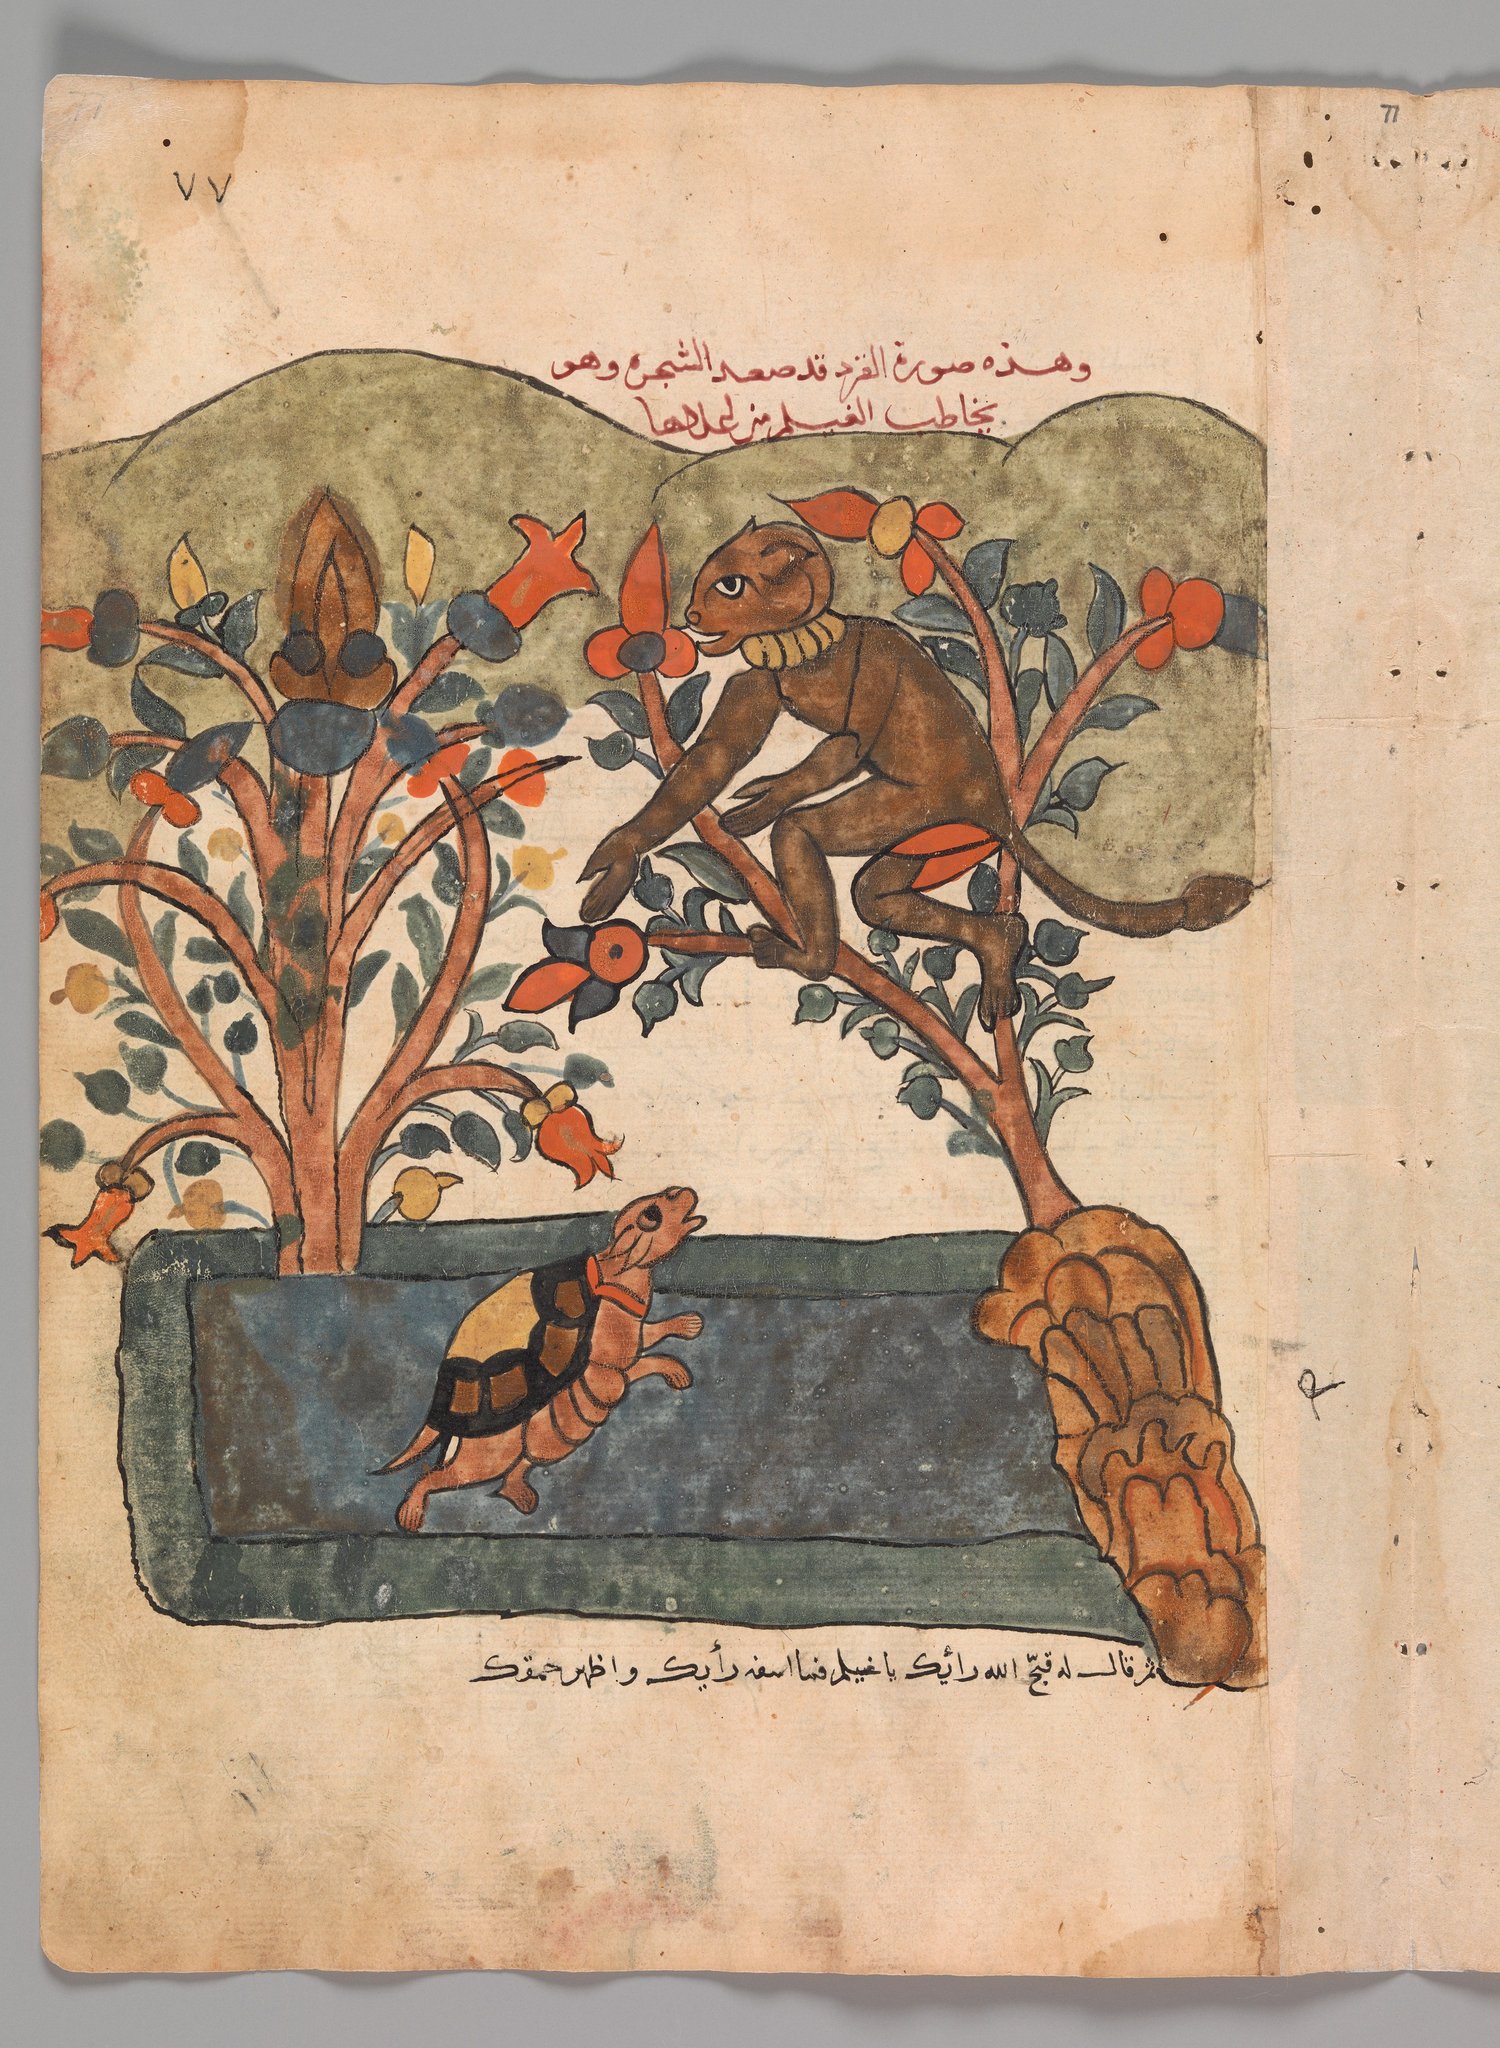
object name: folio from an illustrated manuscript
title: "The Monkey Escapes to the Safety of the Fig Tree", Folio from a Kalila wa Dimna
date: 1526-1550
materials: ink, paper, watercolor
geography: india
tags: monkeys,turtles,trees